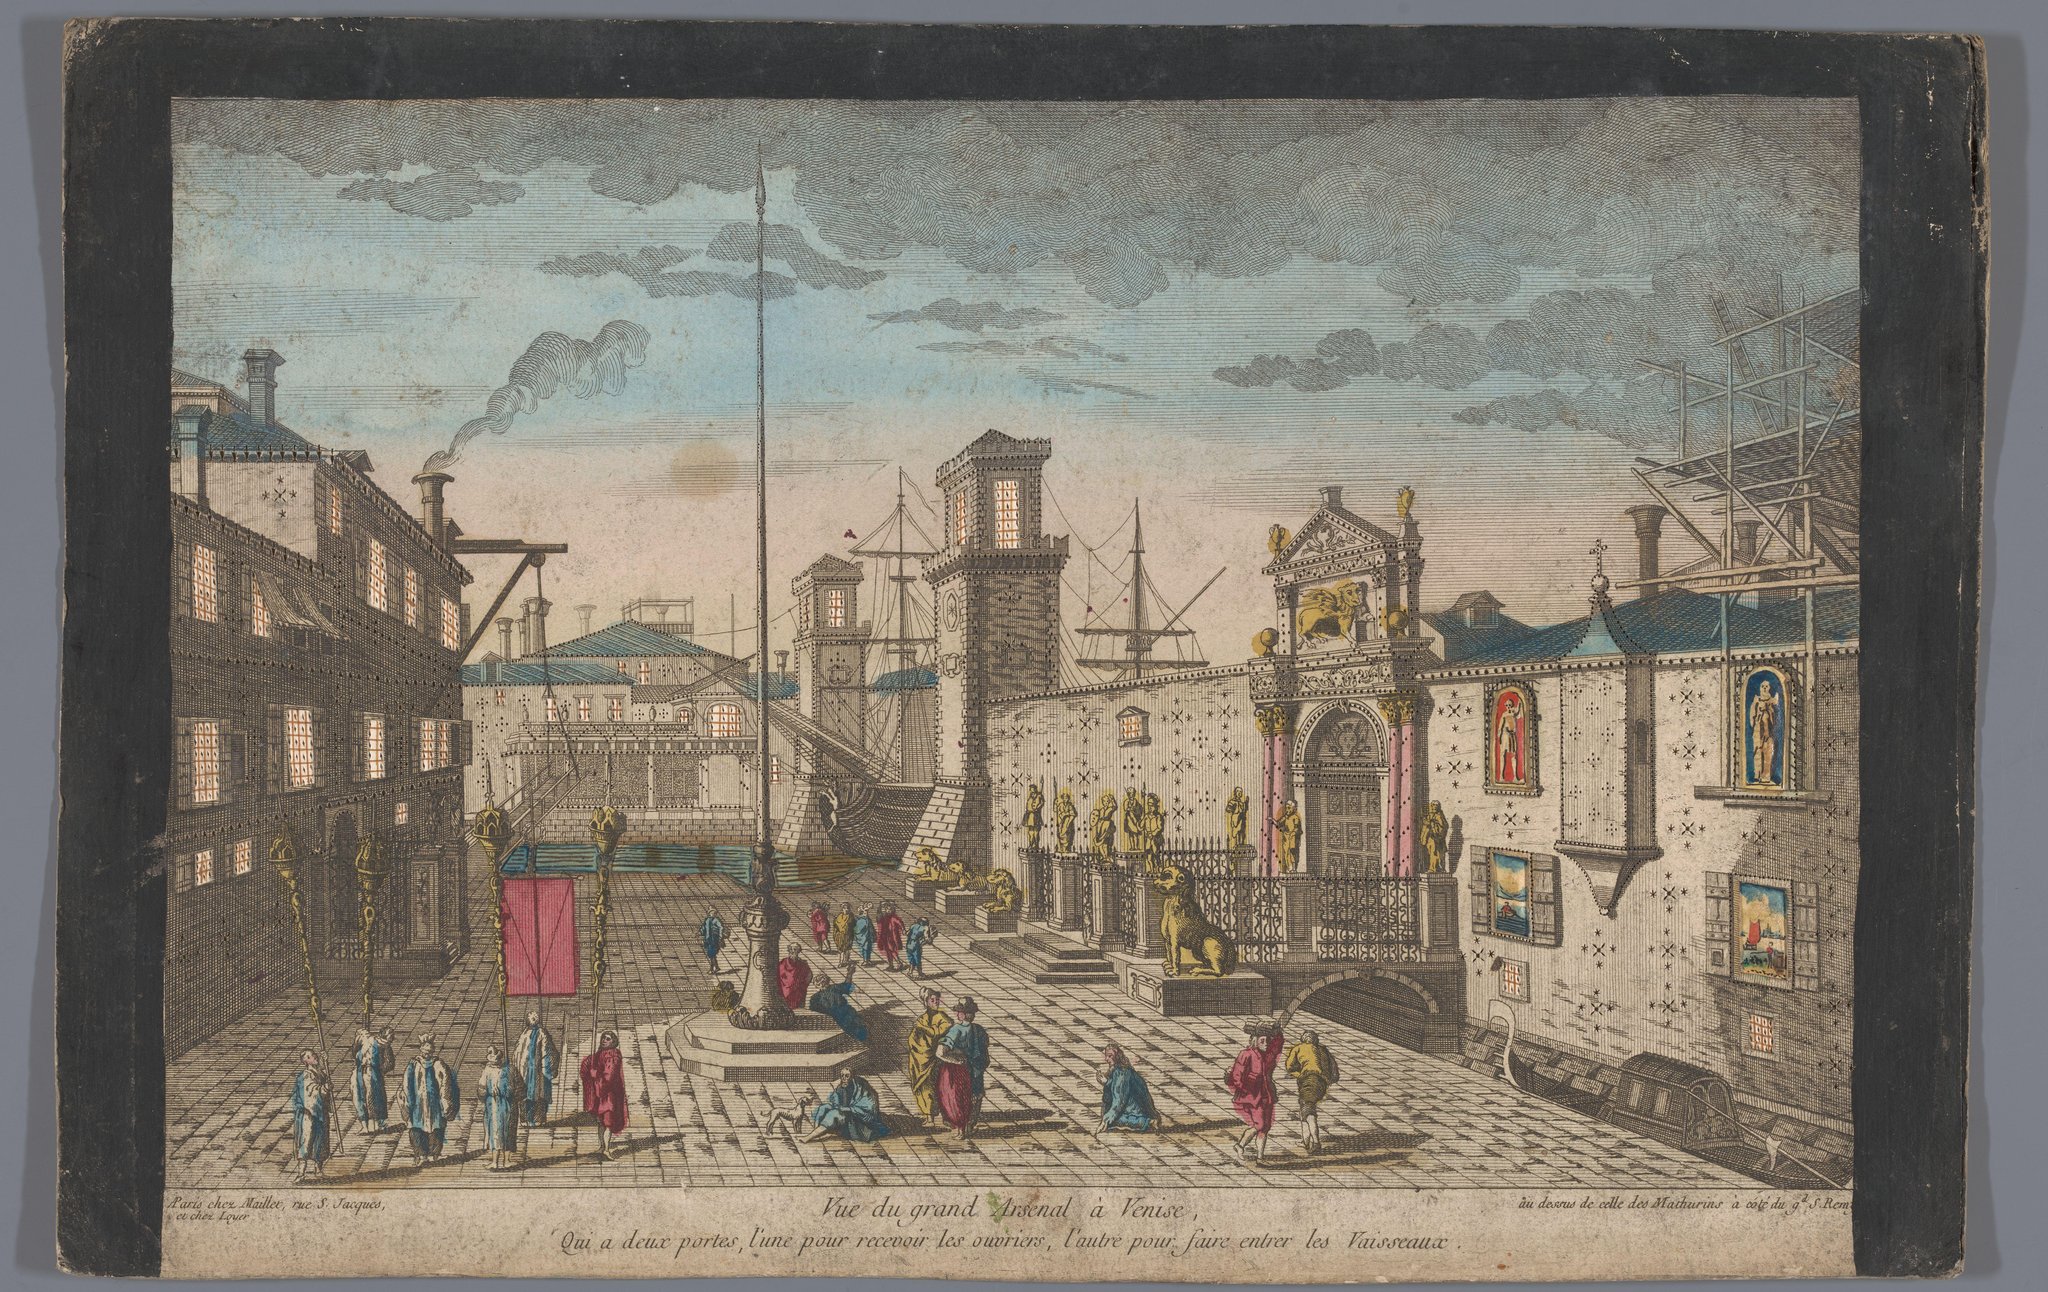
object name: print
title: Gezicht op het Arsenale te Venetië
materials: cardboard, paint, paper, watercolor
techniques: brush, cutting, etching, perforating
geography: france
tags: sailing-ship, sailing-boat, gondola, square, place, circus, etc. (+ city(-scape) with figures, staffage), ammunition store, arsenal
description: In de prent is een aantal delen weggesneden waar vervolgens met penseel is getekend.